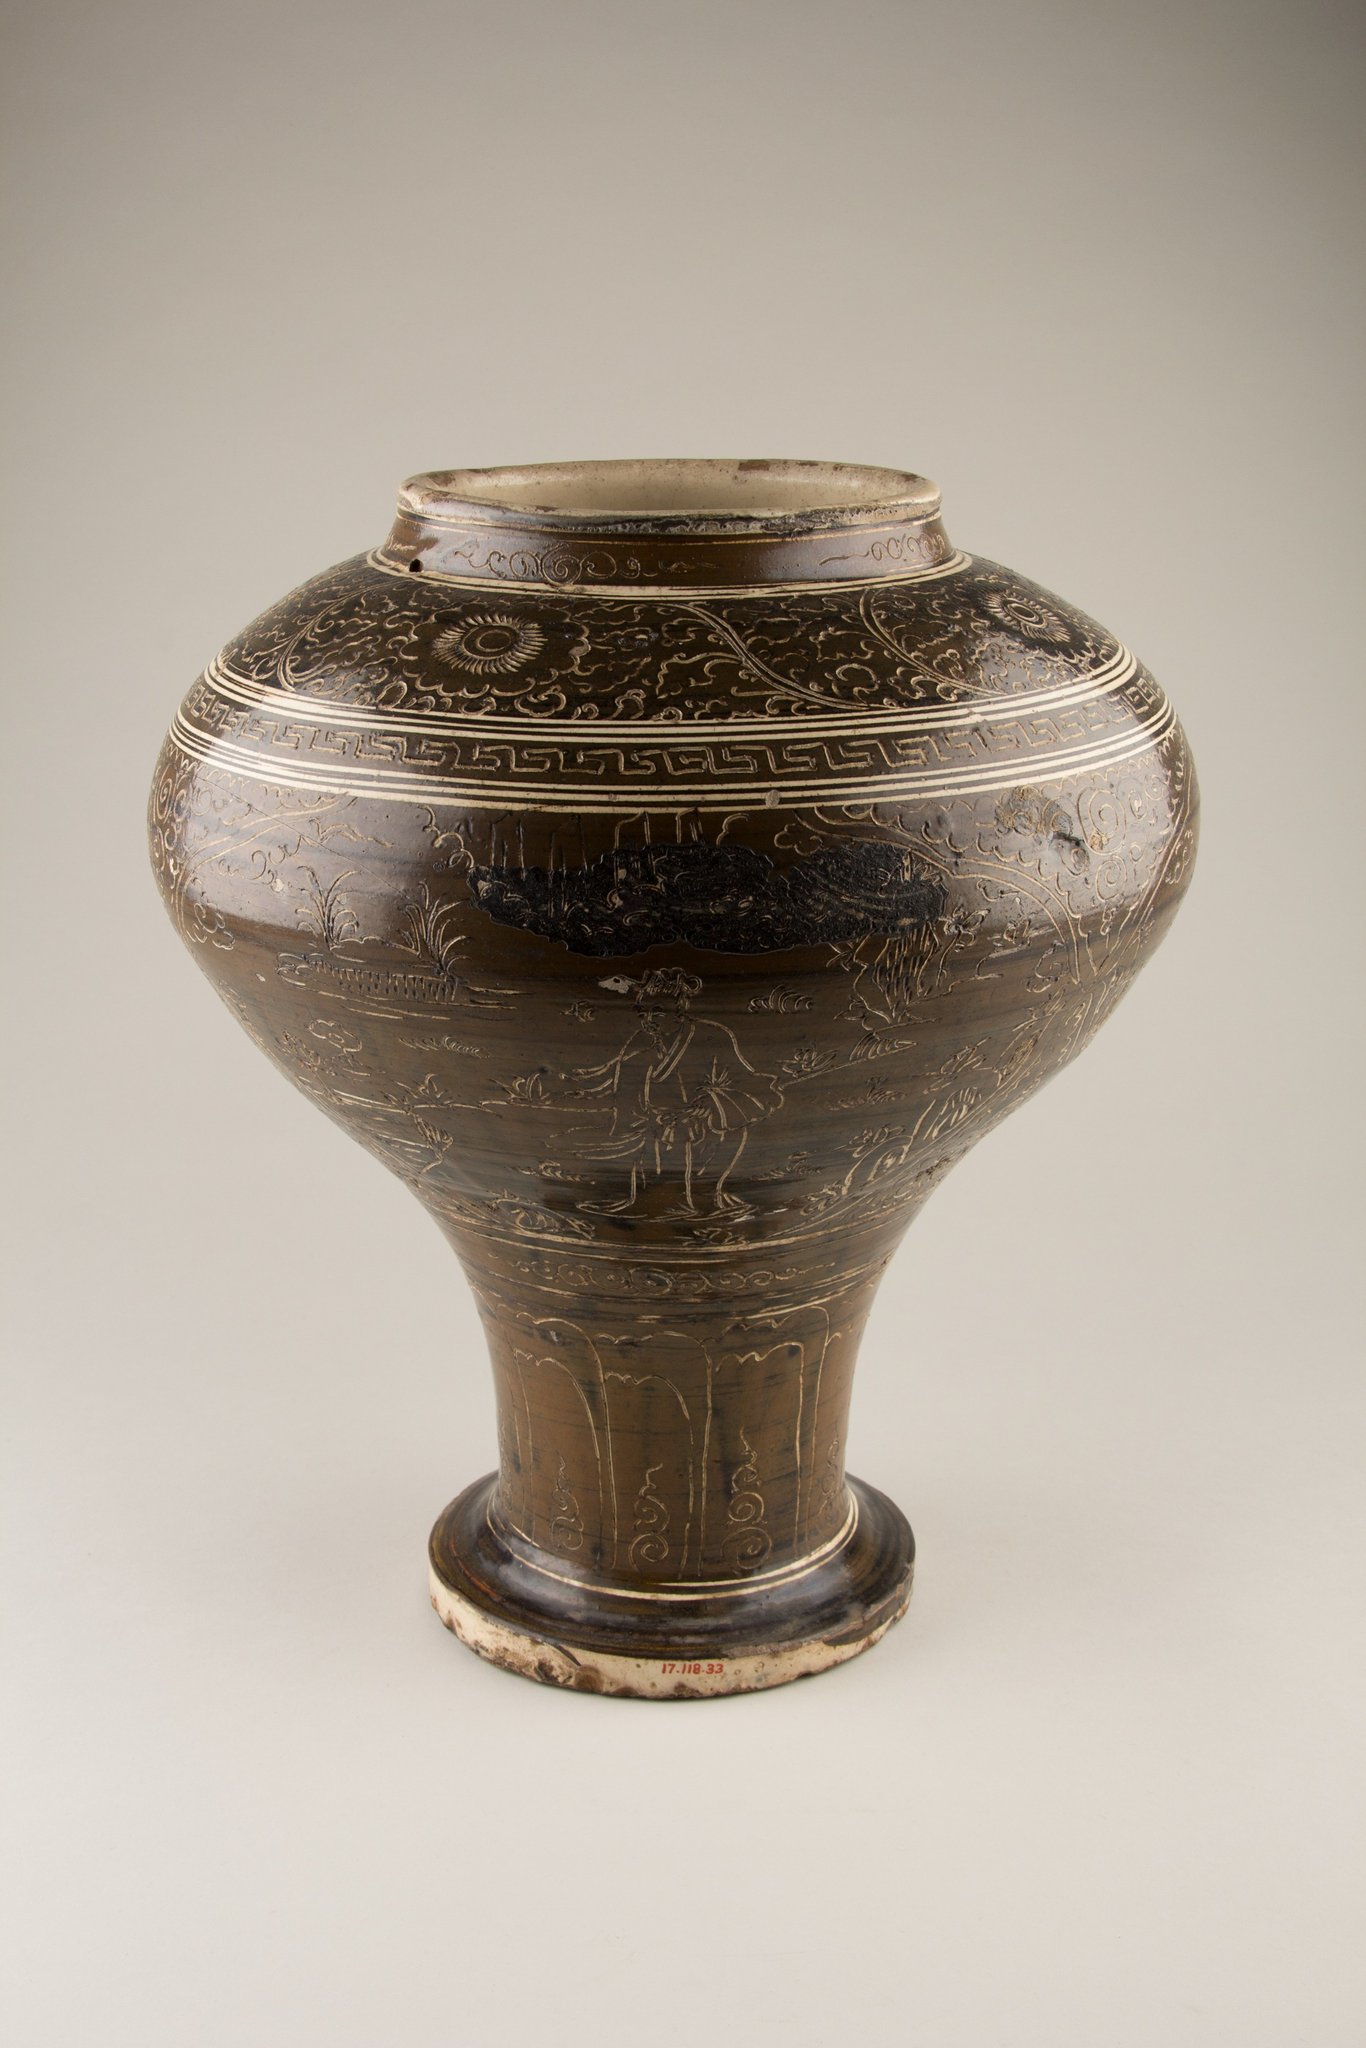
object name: jar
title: Jar with scholars and crane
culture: chinese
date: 1401-1600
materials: stoneware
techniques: incising